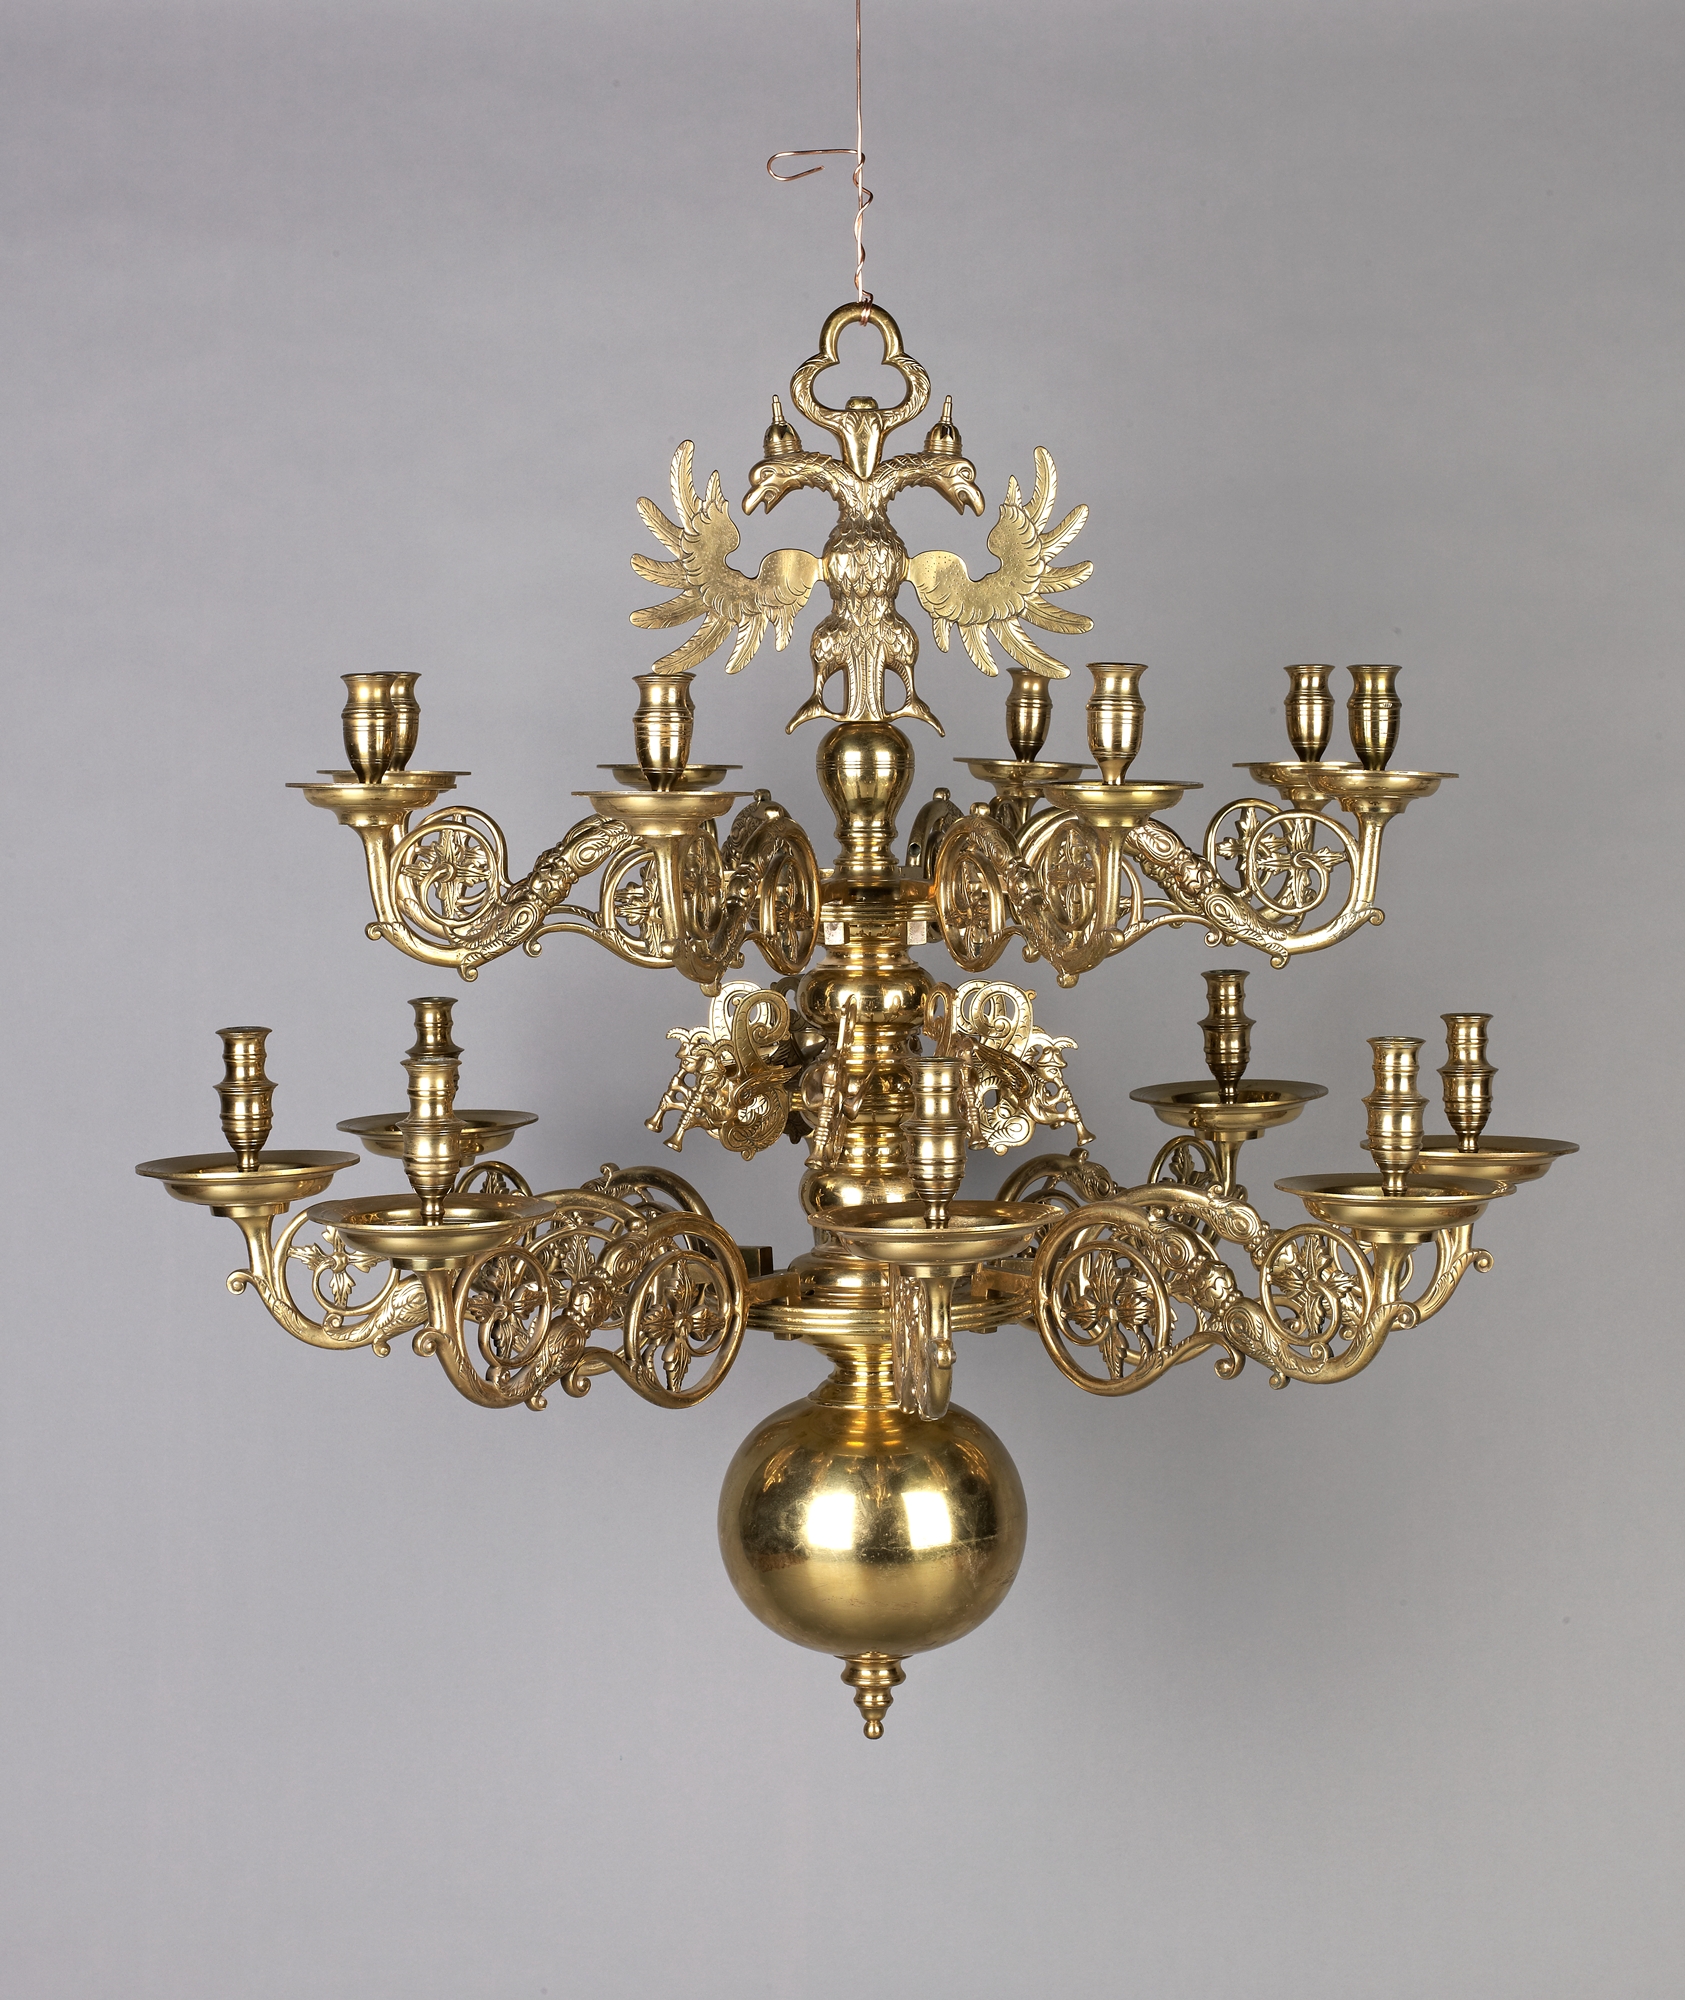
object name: chandelier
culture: german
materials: brass